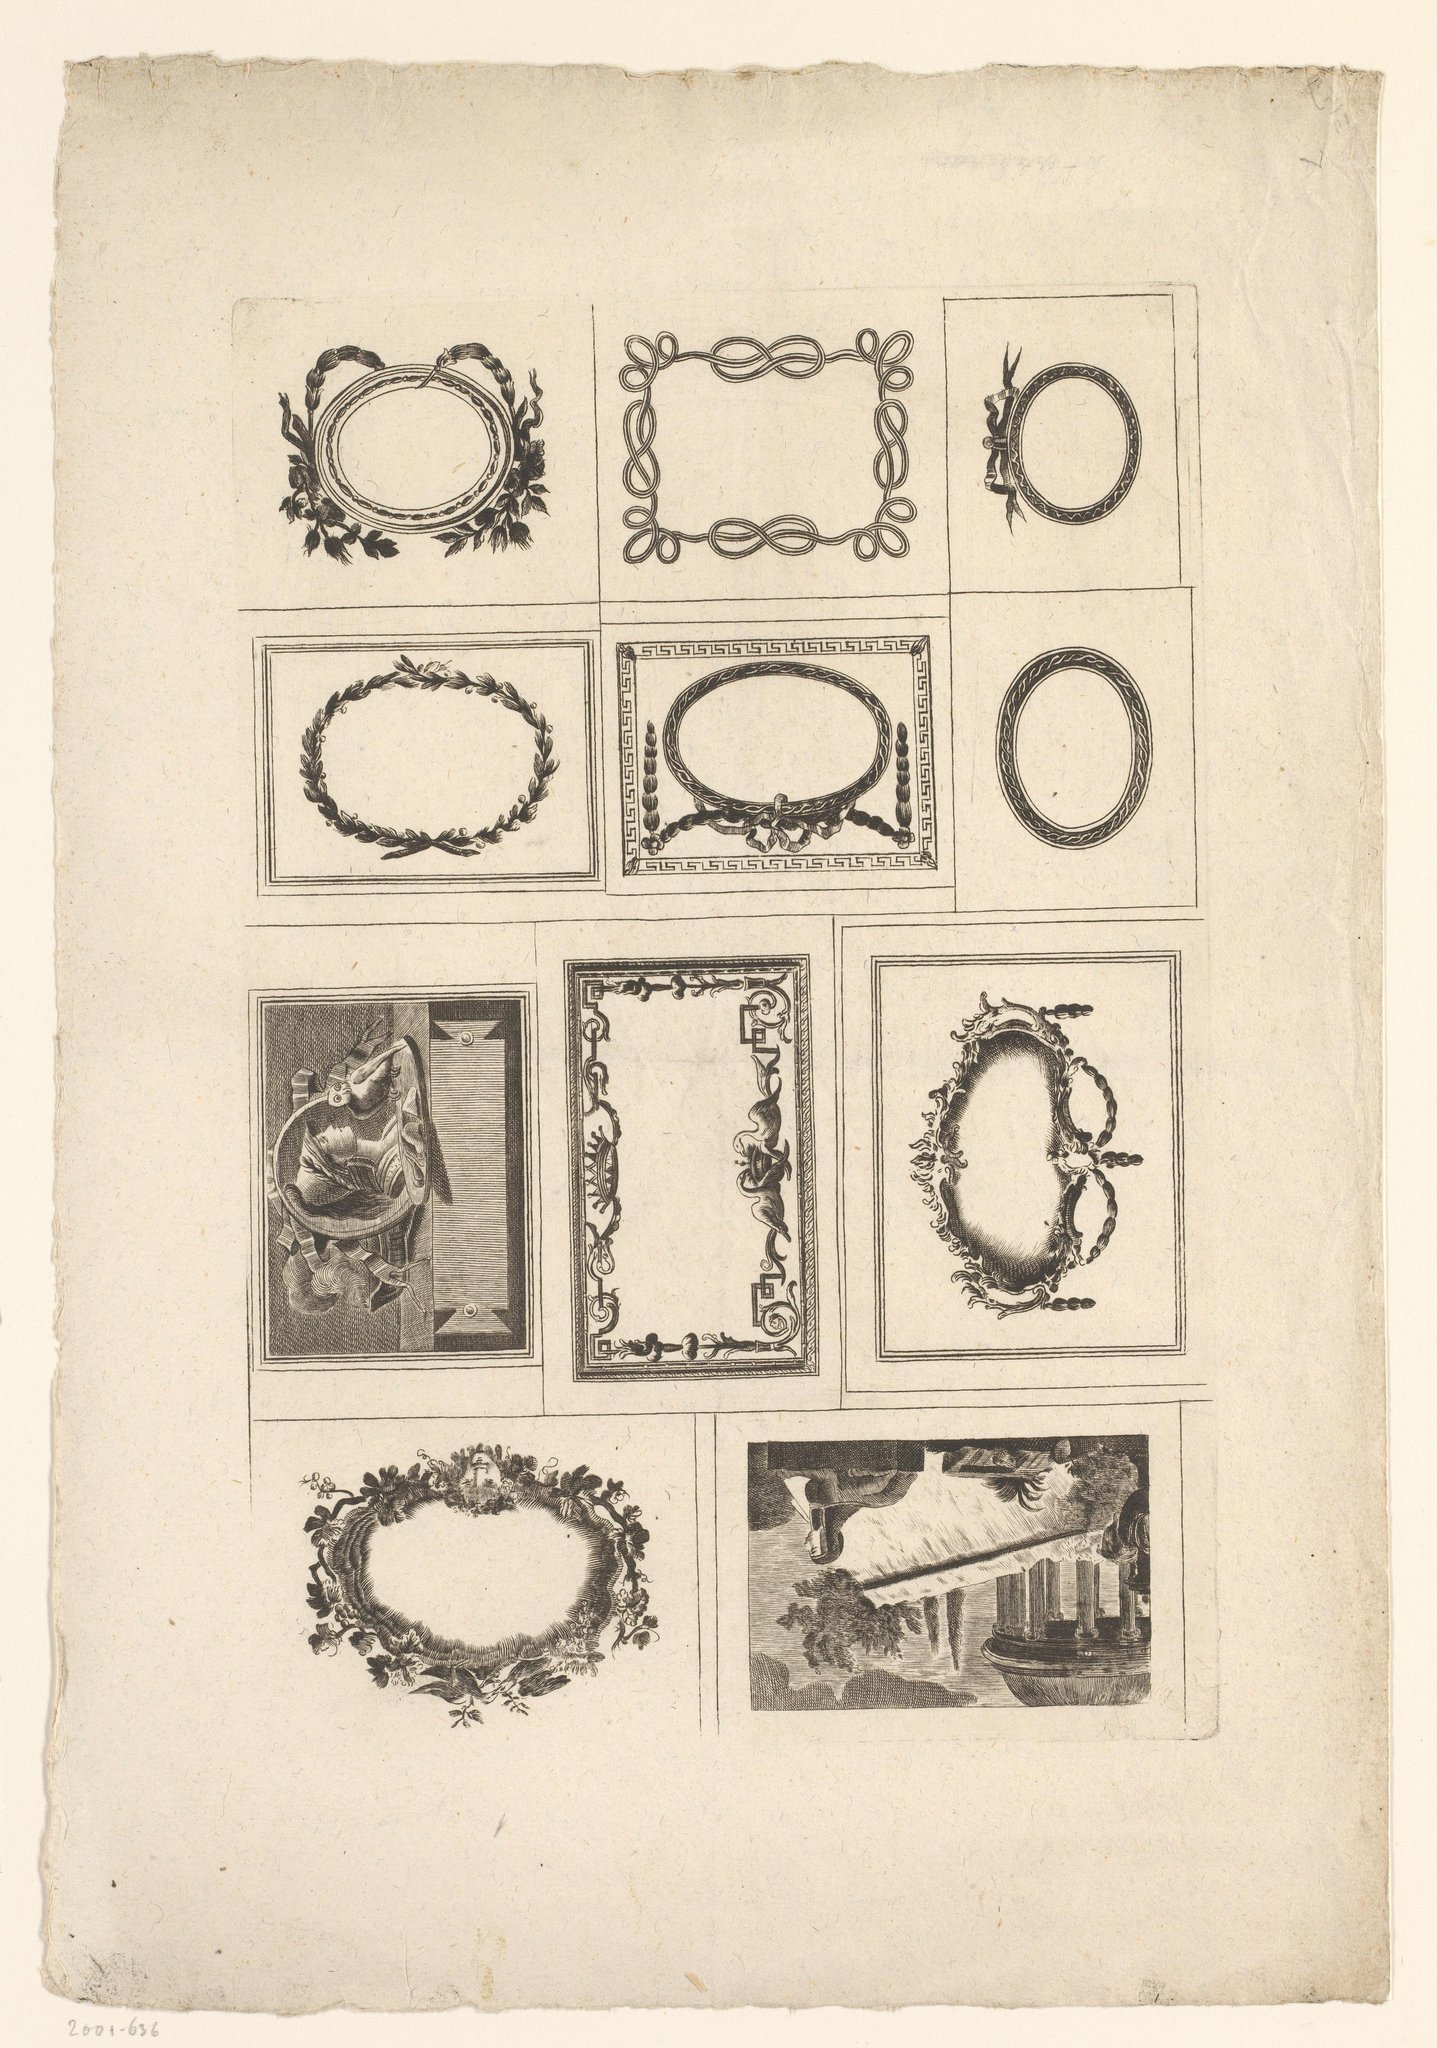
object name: print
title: Elf ontwerpen voor visitekaartjes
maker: Anonymous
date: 1700-1799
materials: paper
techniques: engraving, etching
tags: sphinx (lion/woman); 'sfinge' (ripa), (story of) minerva (pallas, athena), ornament ~ cartouche, visiting-card, calling-card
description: Ovale cartouches, een landschap met tempel, waterval en Sfinx, en een portret van Minerva in ovaal. Oningevulde ontwerpen voor visitekaartjes.